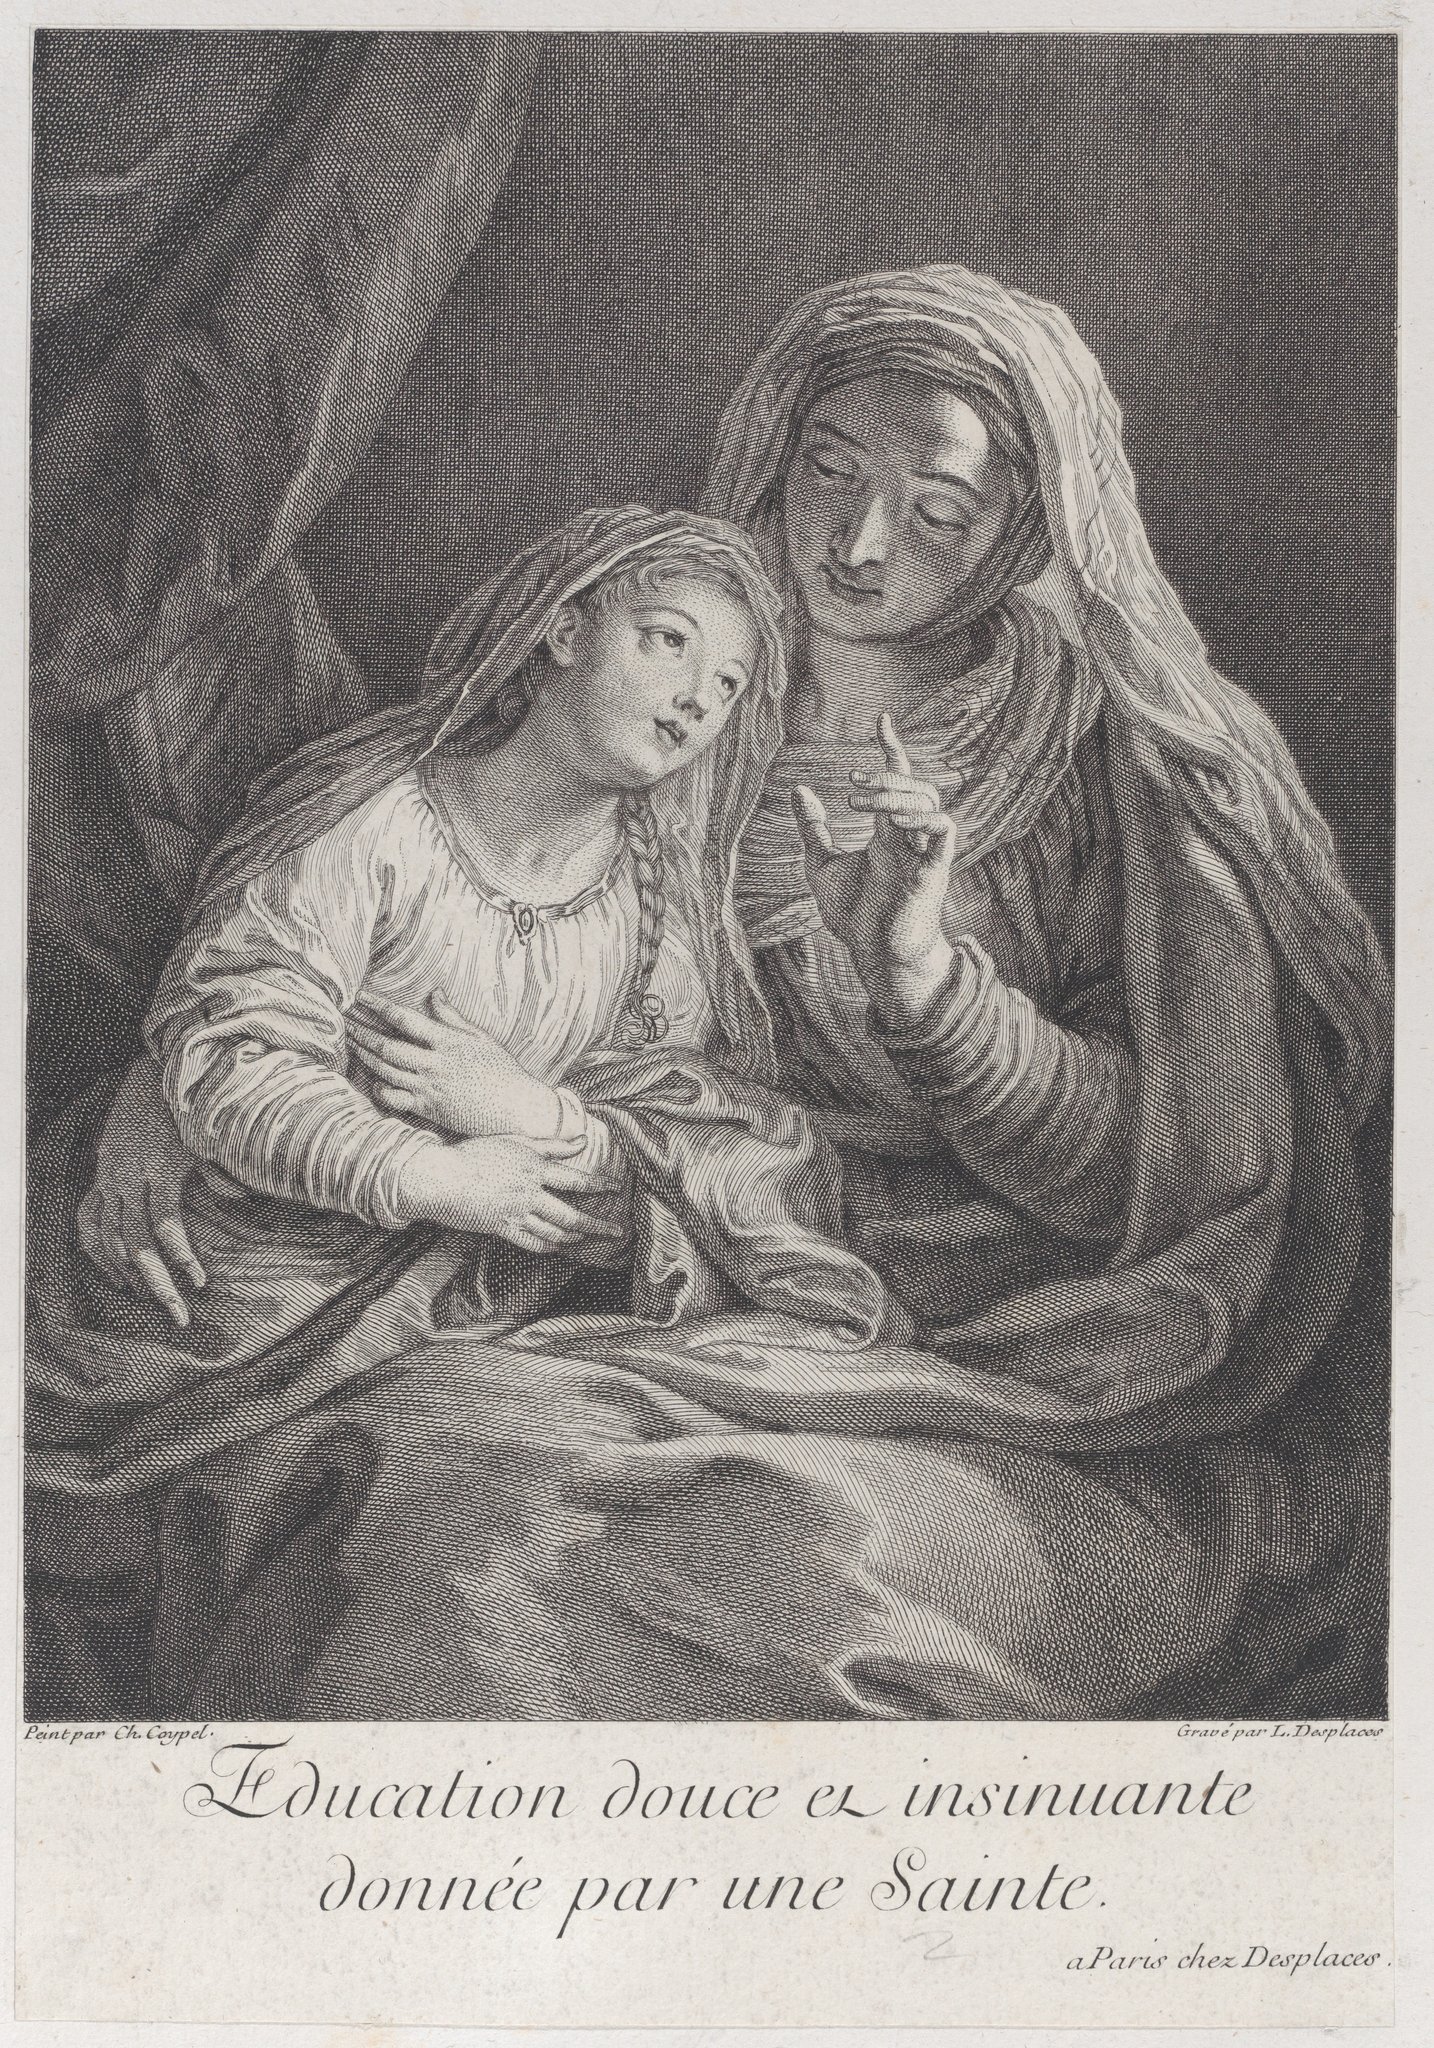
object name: print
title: The sweet and insinuating education given by a saint (Education douce et insinuante donnée par une Sainte)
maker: louis desplaces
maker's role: artist and publisher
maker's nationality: french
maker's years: 1682-1739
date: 1700-1739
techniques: engraving, etching